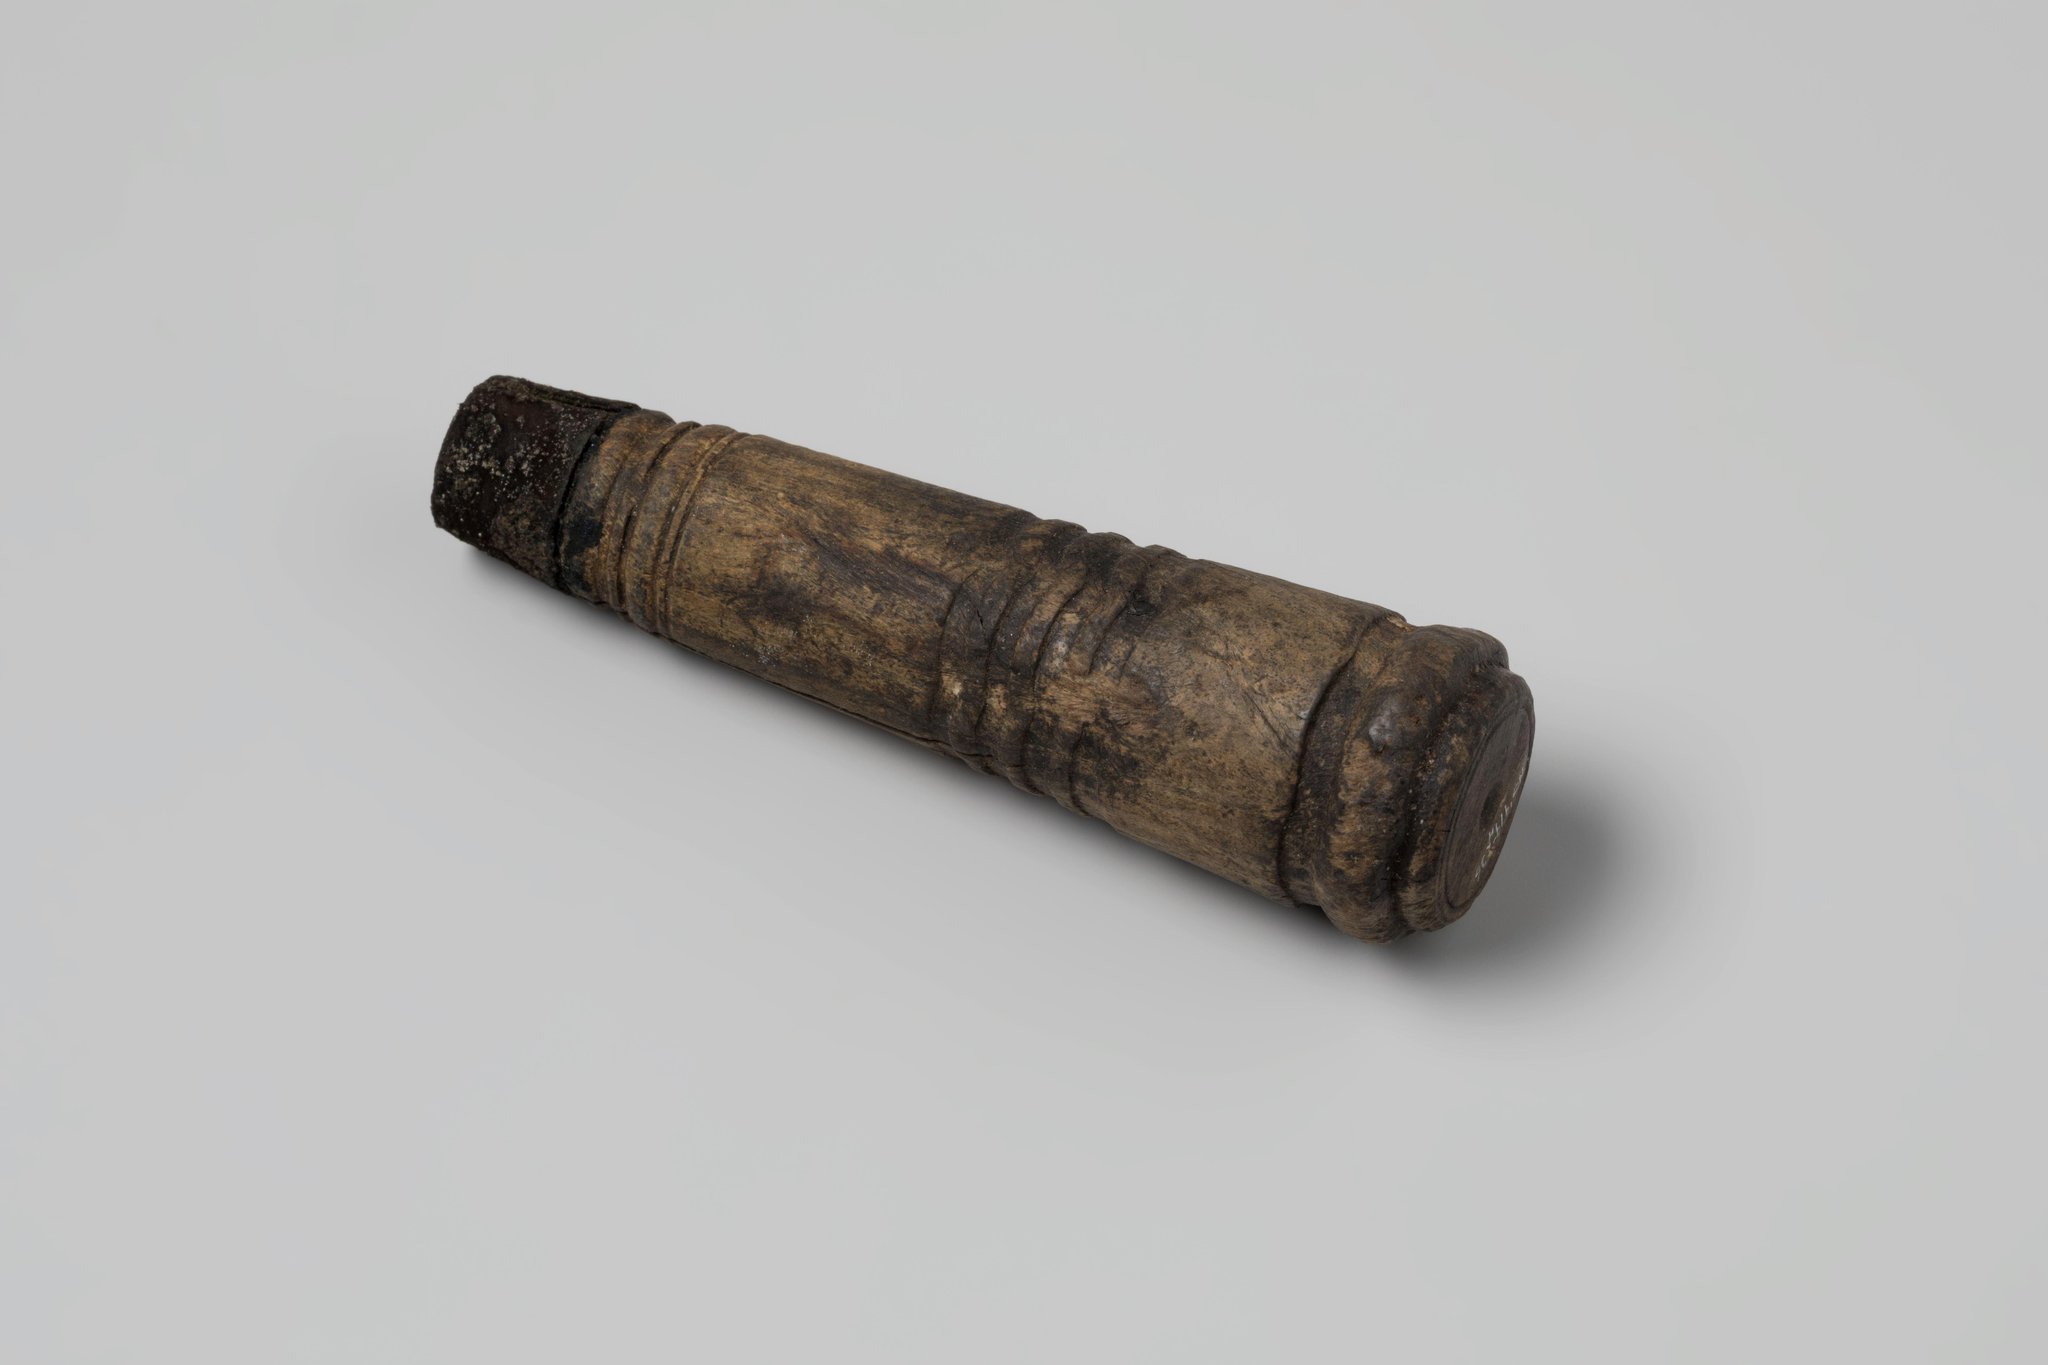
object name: knife handle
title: Messenheft uit het wrak van de Oost-Indiëvaarder Hollandia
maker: Anonymous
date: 1700-1743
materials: metal, wood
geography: netherlands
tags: verenigde oostindische compagnie, hollandia (schip), annet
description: Knife, handle, cylindrical: tapering; knob-shaped flat upper end, turned decoration of wavy lines, concentric circles at lower end, ferrule.